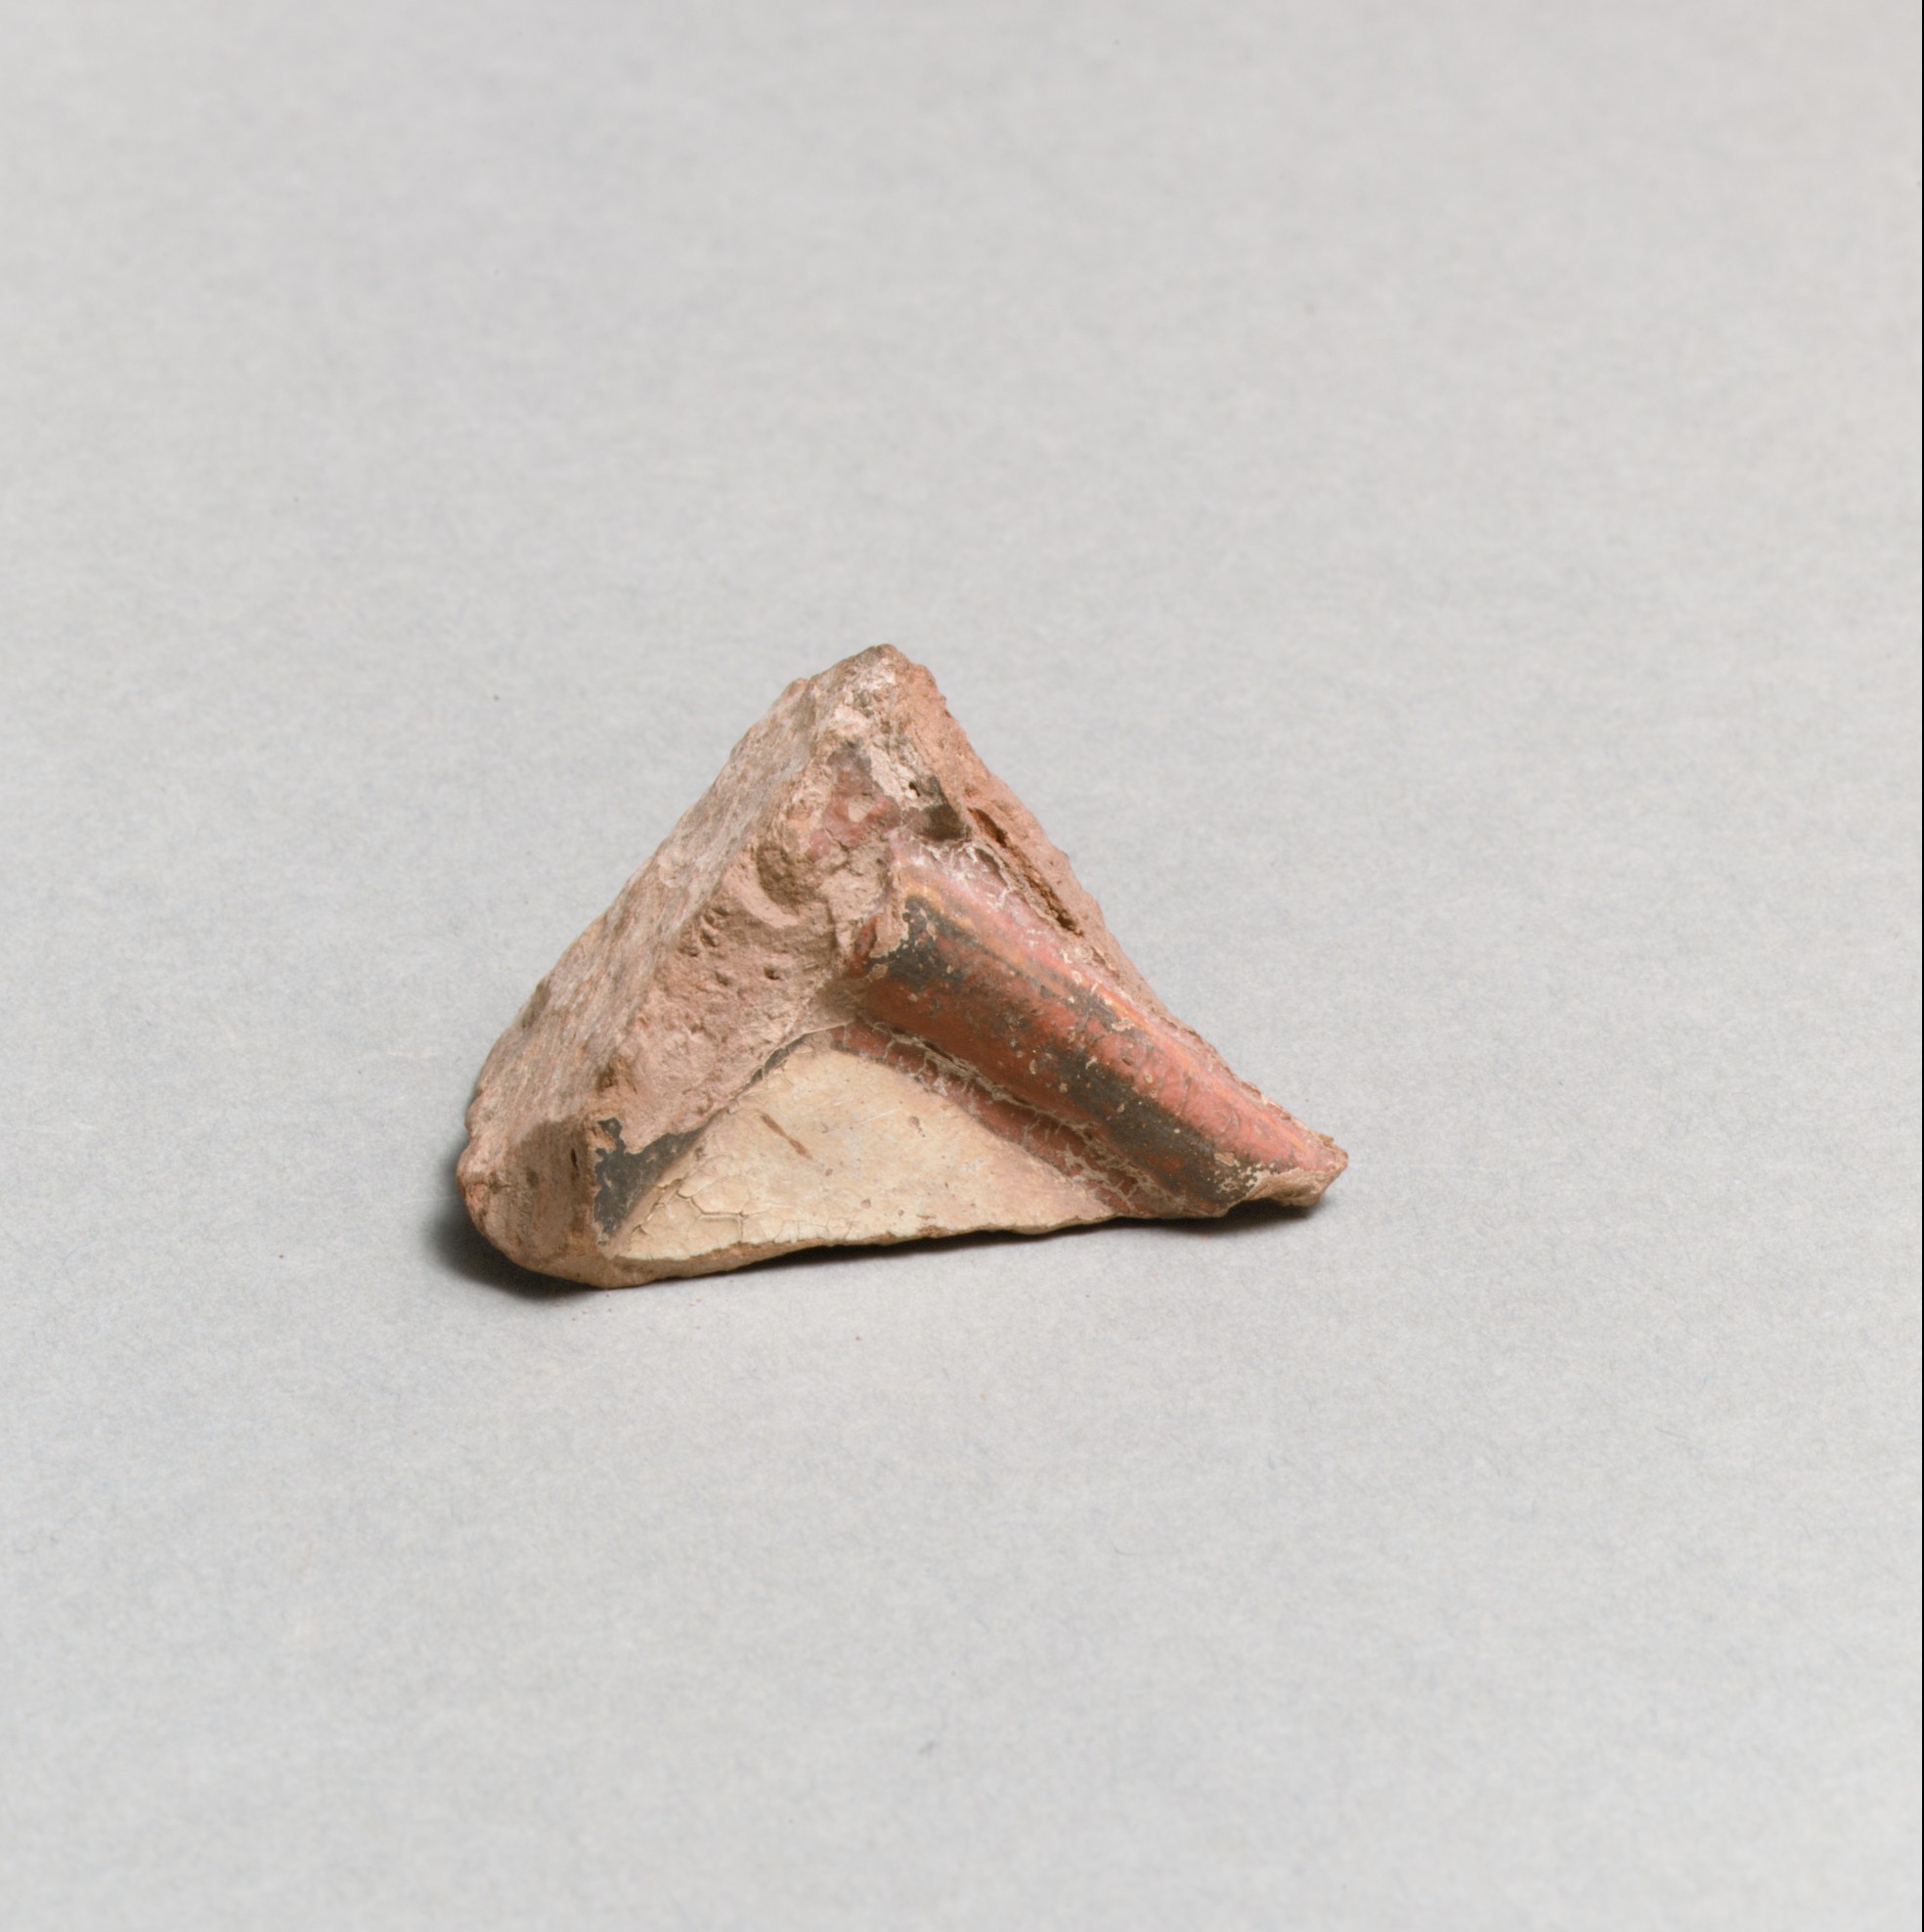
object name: vase fragment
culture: greek or lydian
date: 900-30 BCE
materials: terracotta